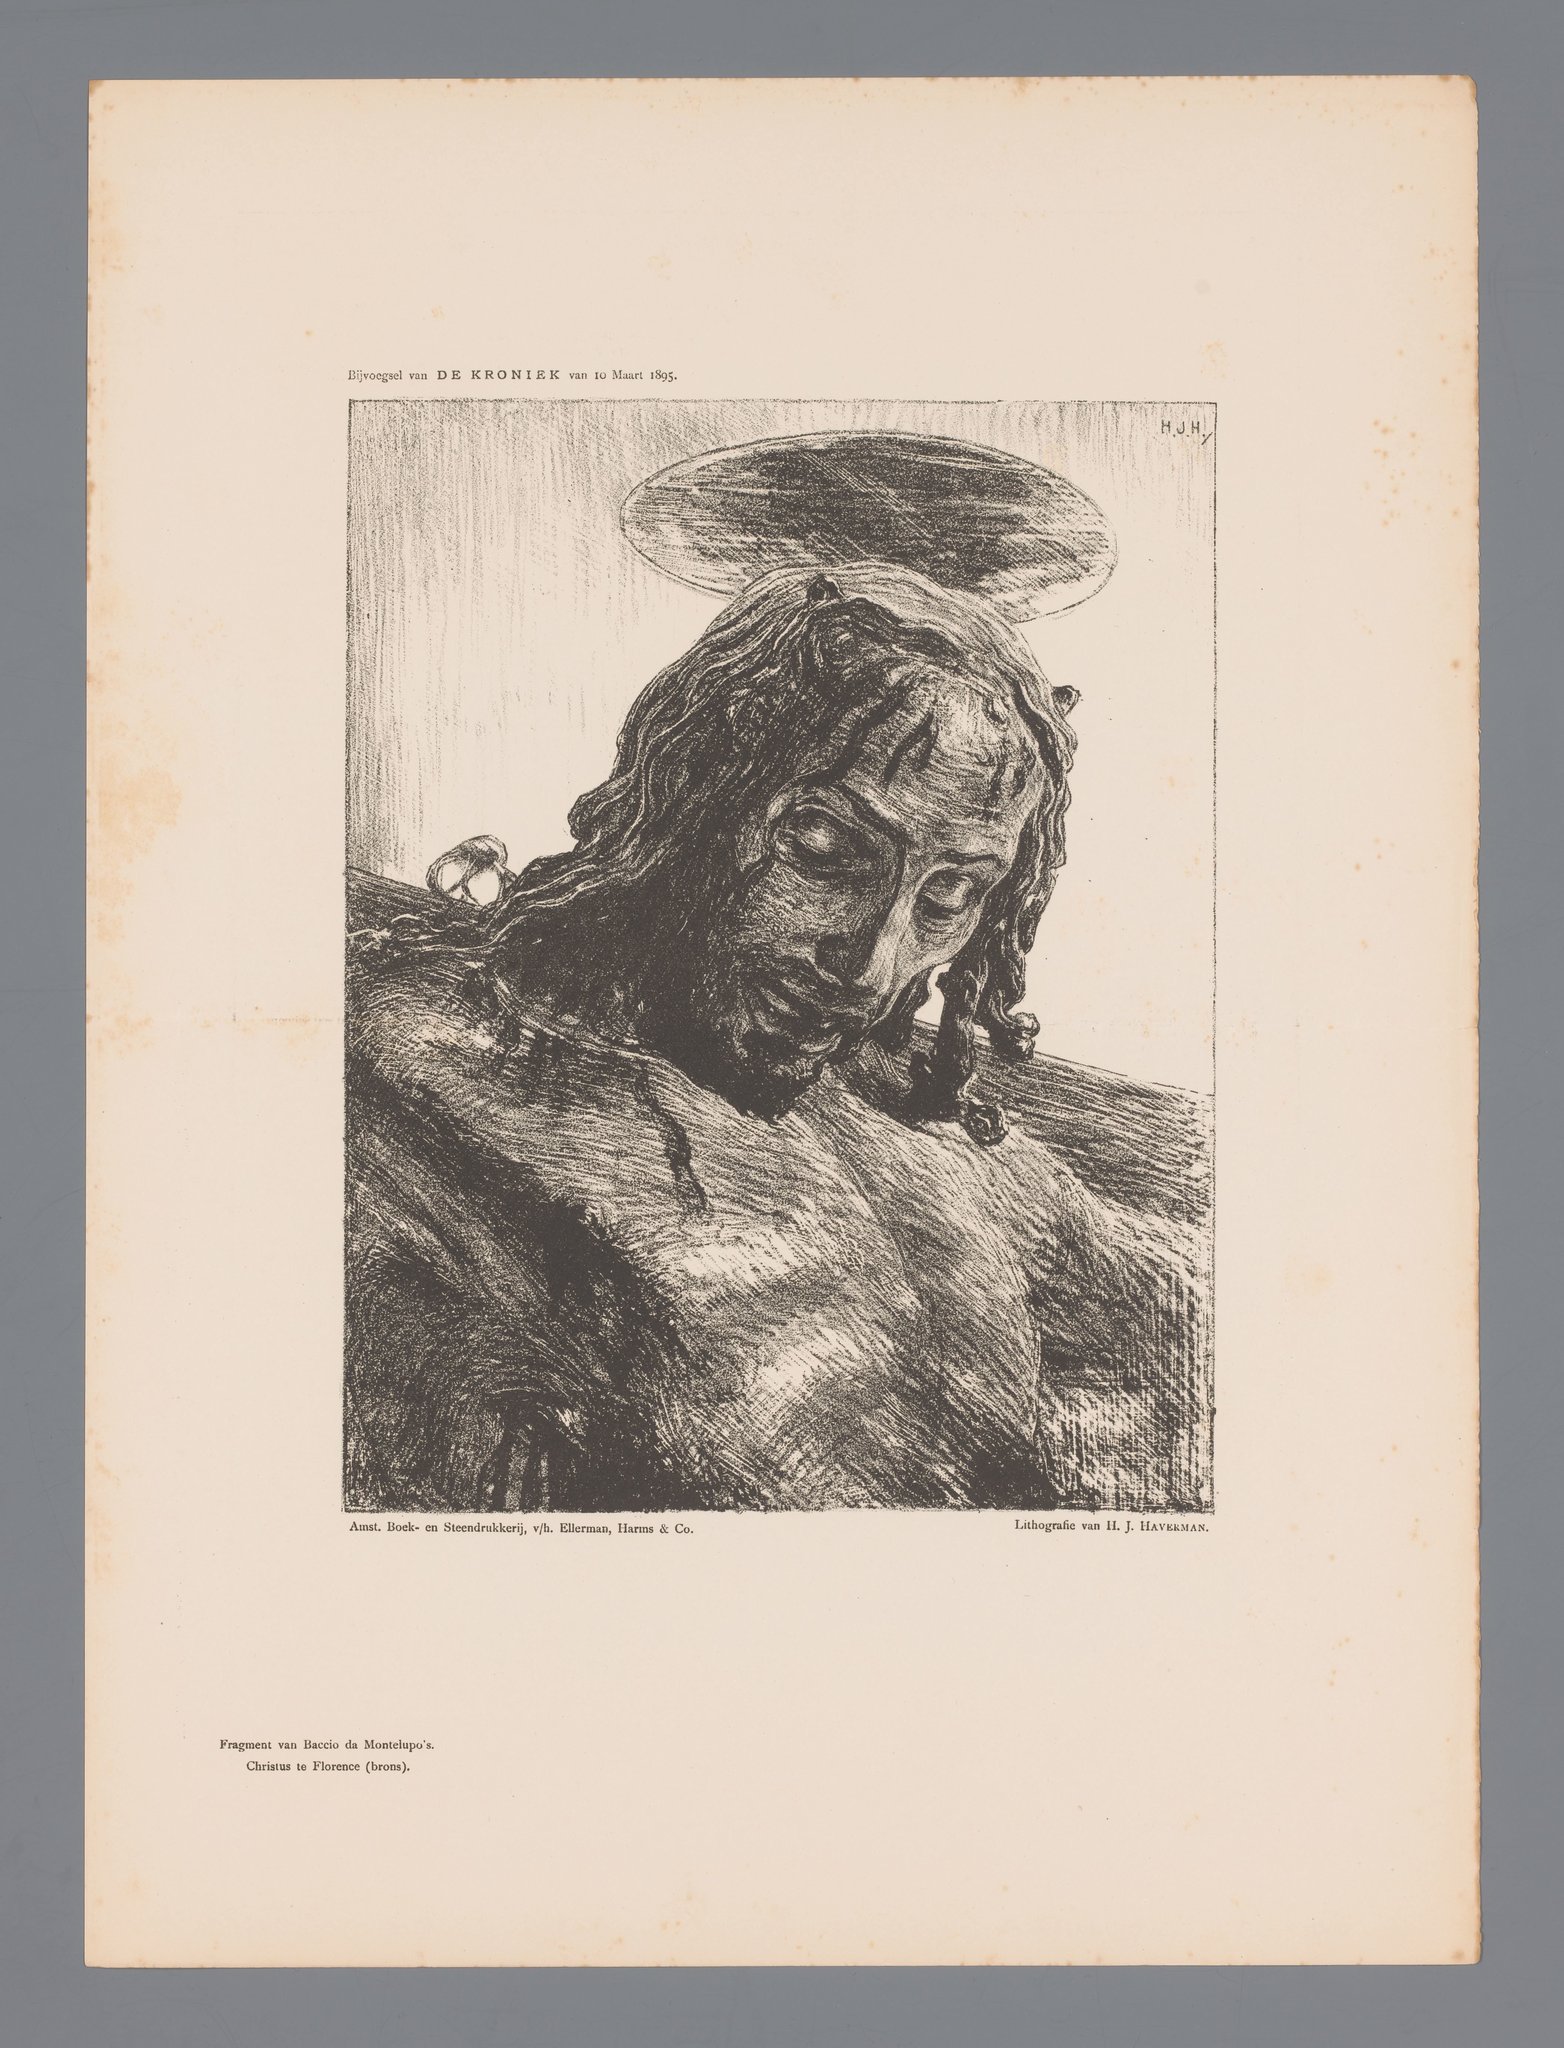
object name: print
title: Fragment van Baccio da Montelupo's Christus te Florence (brons)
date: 1895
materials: paper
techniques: lithograph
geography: amsterdam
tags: christ as adult, sculpture, the crucifixion of christ: christ's death on the cross; golgotha (matthew 27:45-58; mark 15:33-45; luke 23:44-52; john 19:25-38)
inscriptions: date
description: Prent uit het bijvoegsel van: De Kroniek 1 (1895), 10 maart 1895.